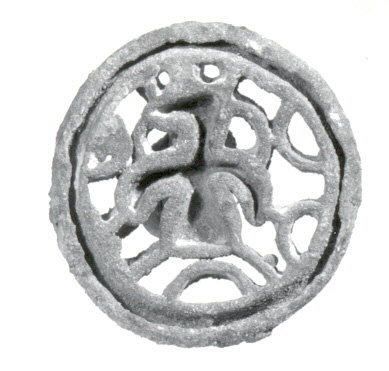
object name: stamp seal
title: Compartmented stamp seal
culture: bactria-margiana archaeological complex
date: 2333-1668 BCE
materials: copper alloy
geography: bactria-margiana